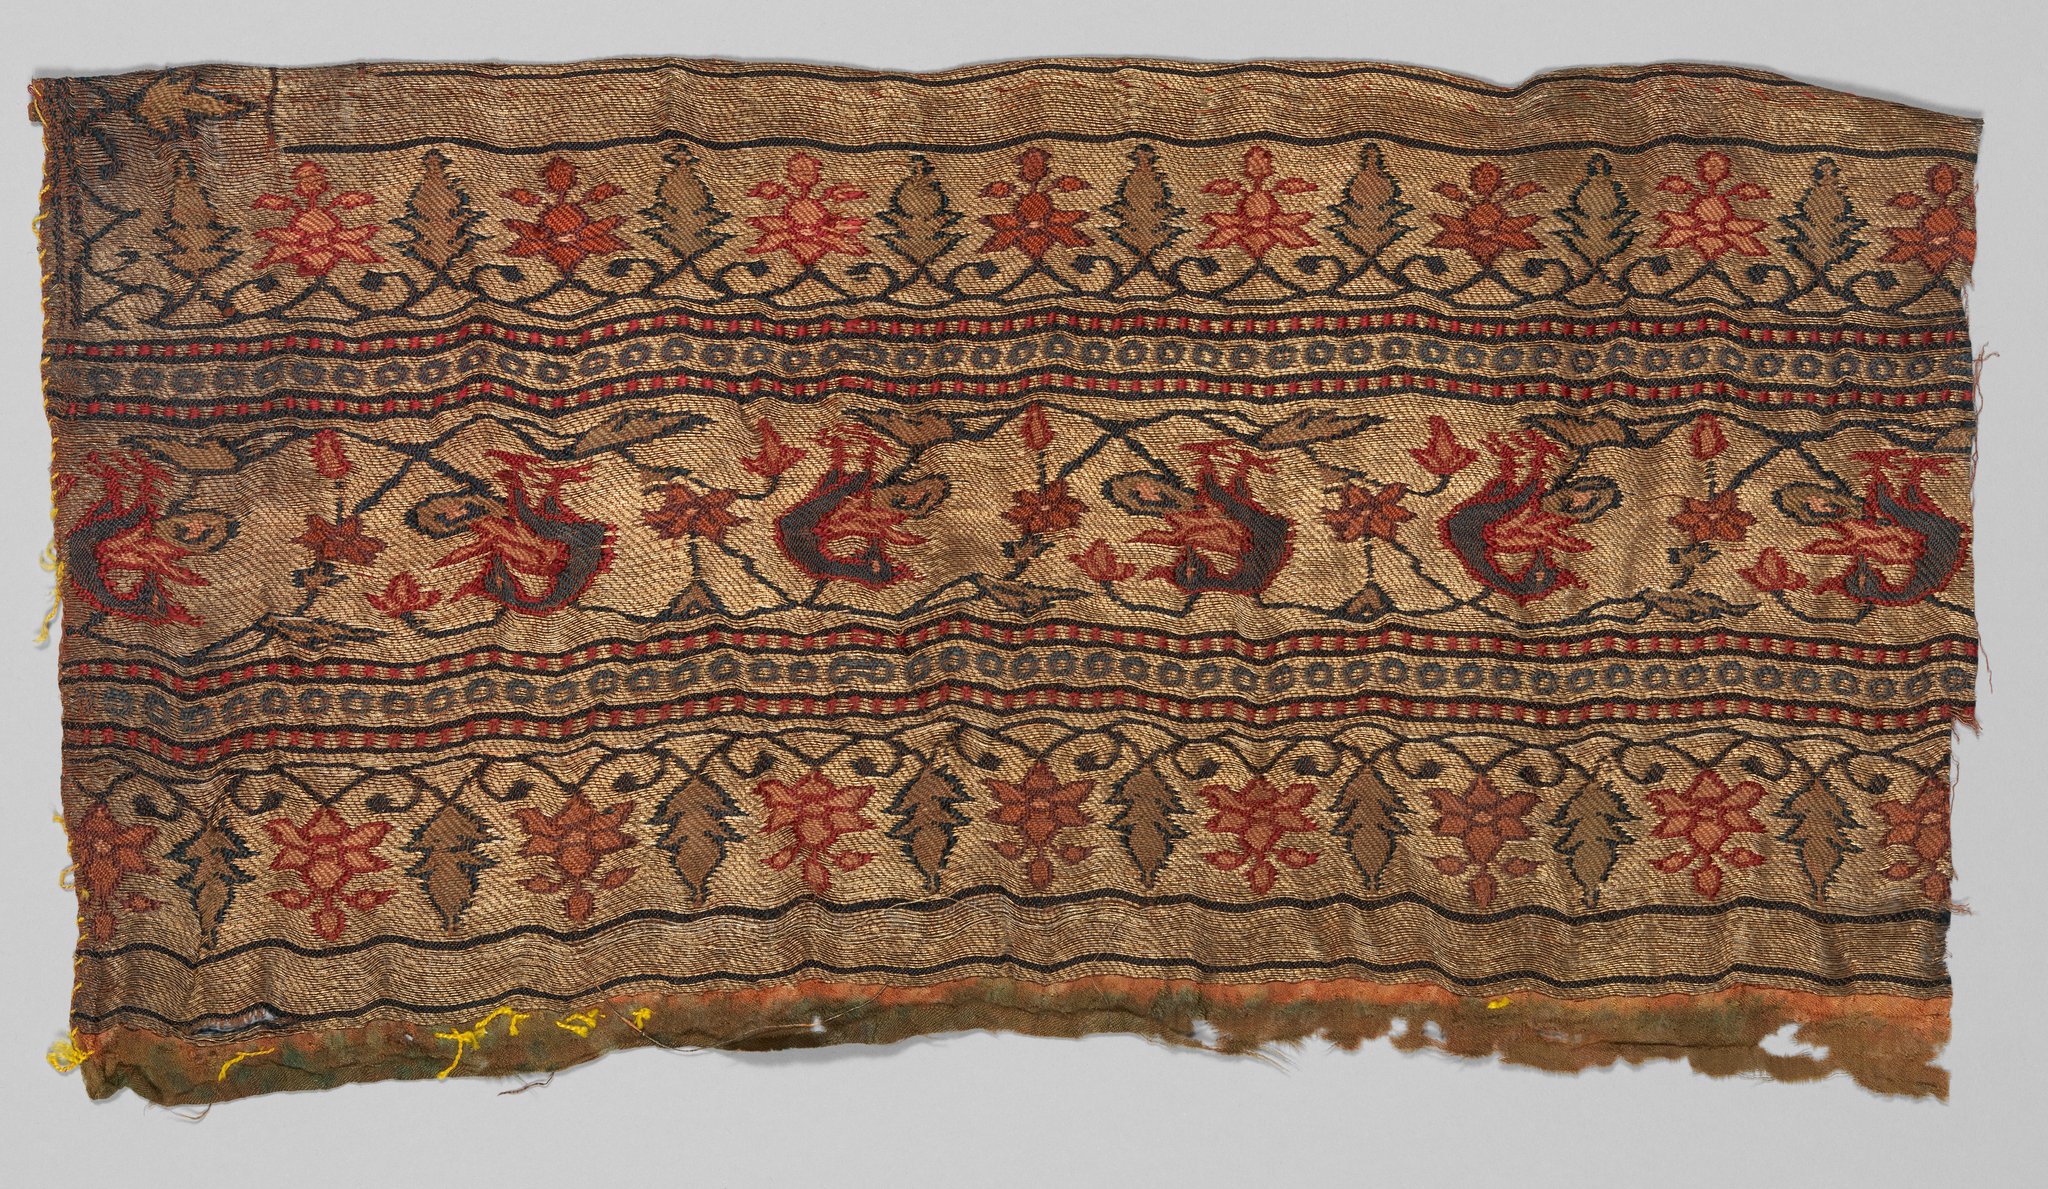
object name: textile fragment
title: Four Chandanri Sari Border Fragments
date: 1701-1800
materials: metal thread, silk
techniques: brocade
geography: india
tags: flowers